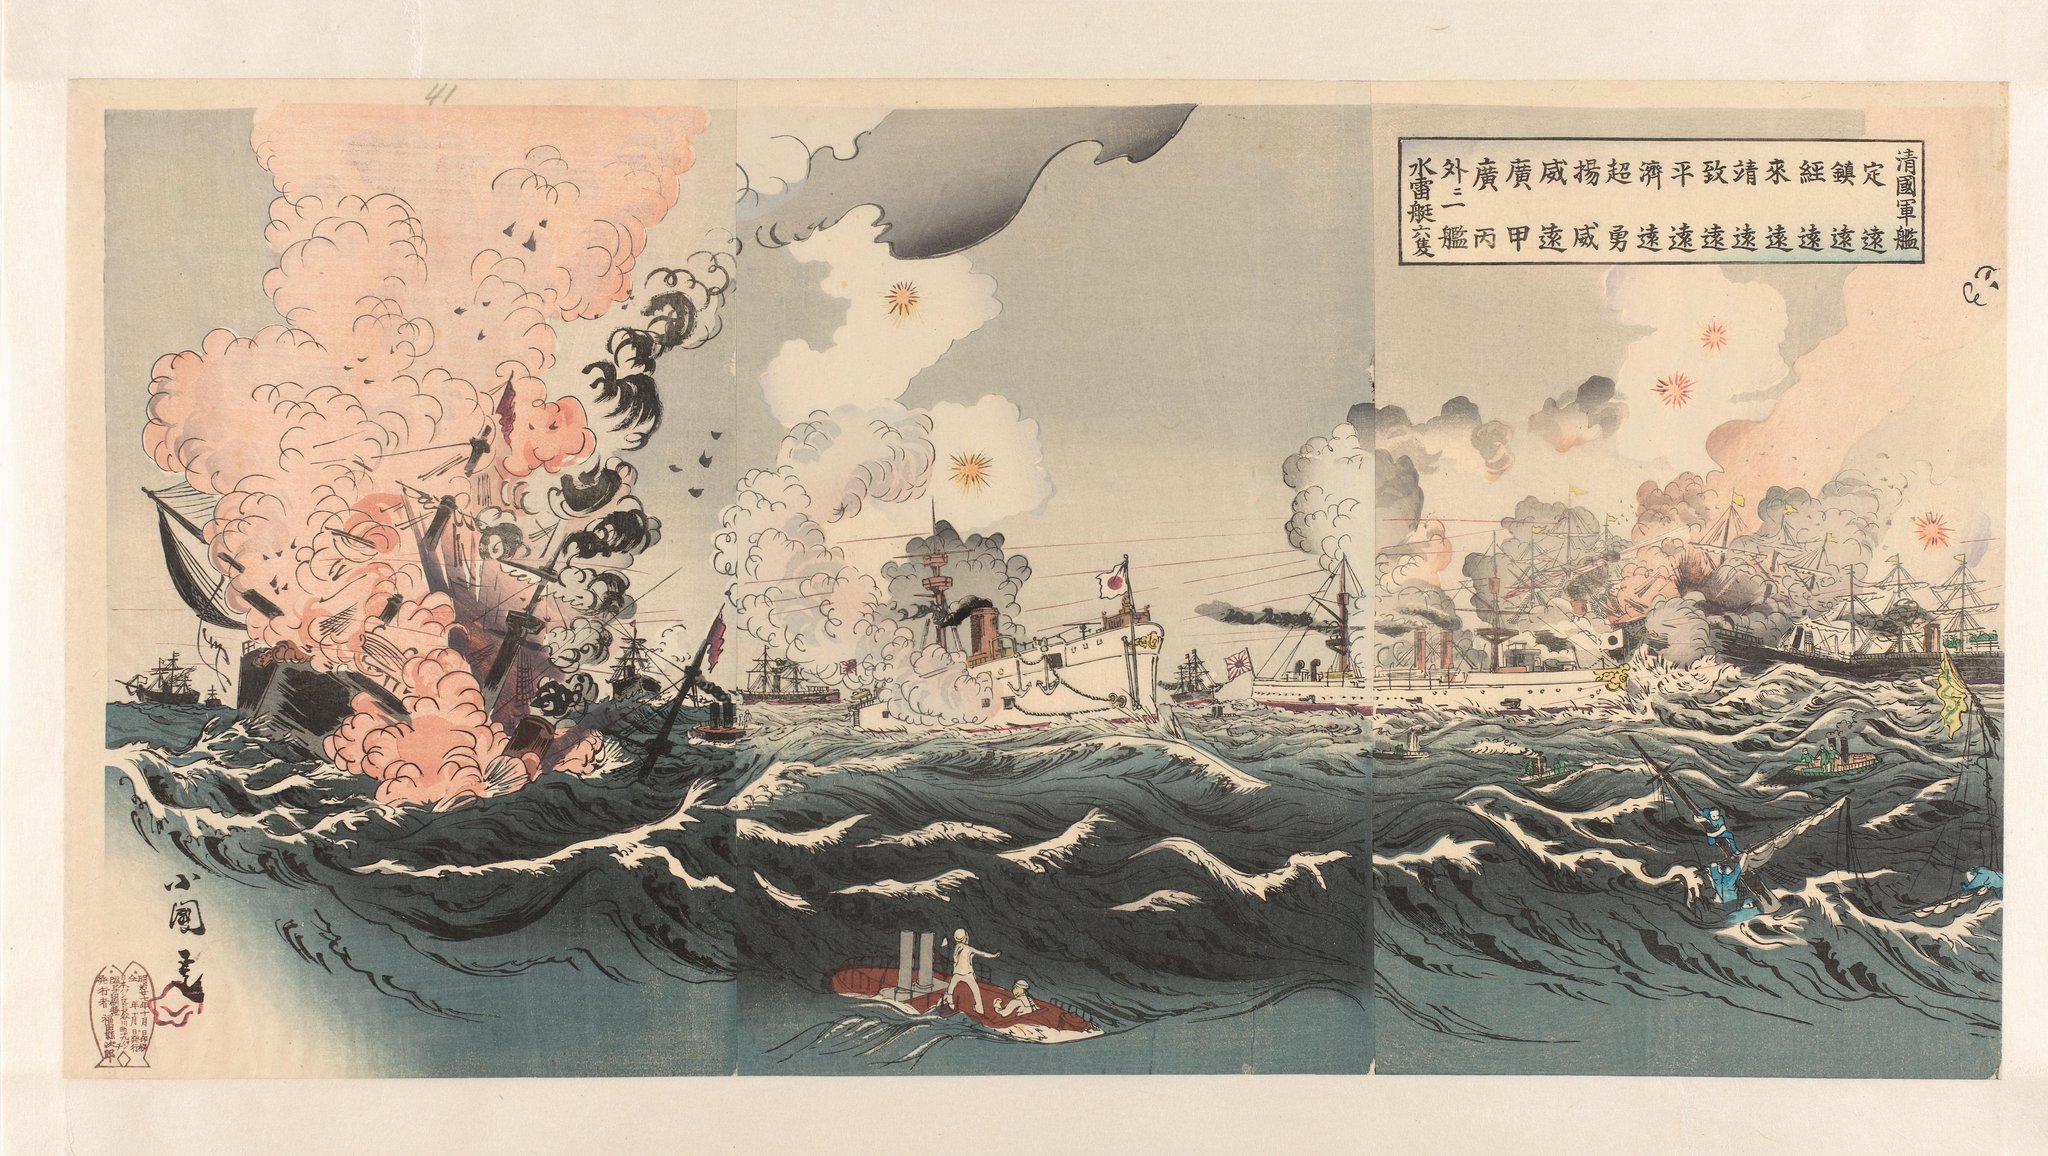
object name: polyptych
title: Nisshin kaisen Daikosan oki daigekisen: Dai Nihon kaigun daishôri no zu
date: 1894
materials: paper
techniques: woodcut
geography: japan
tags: battle (+ naval force), ships (in general) - cc - more than one ship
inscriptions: date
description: De overwinning van Japan bij de Slag van de Gele Zee, ook bekend als de zeeslag nabij Dagushan, gaf Japan controle over het gehele Gele Zee gebied. Het Japanse vlaggenschip was de Matsushima, samen met twaalf andere oorlogsschepen. Op 17 september 1894 won de Japanse vloot de zeeslag na vijf uur strijden, meerdere Chinese schepen vergingen maar geen enkel Japans schip sneuvelde. Linkerdeel van een zesluik.